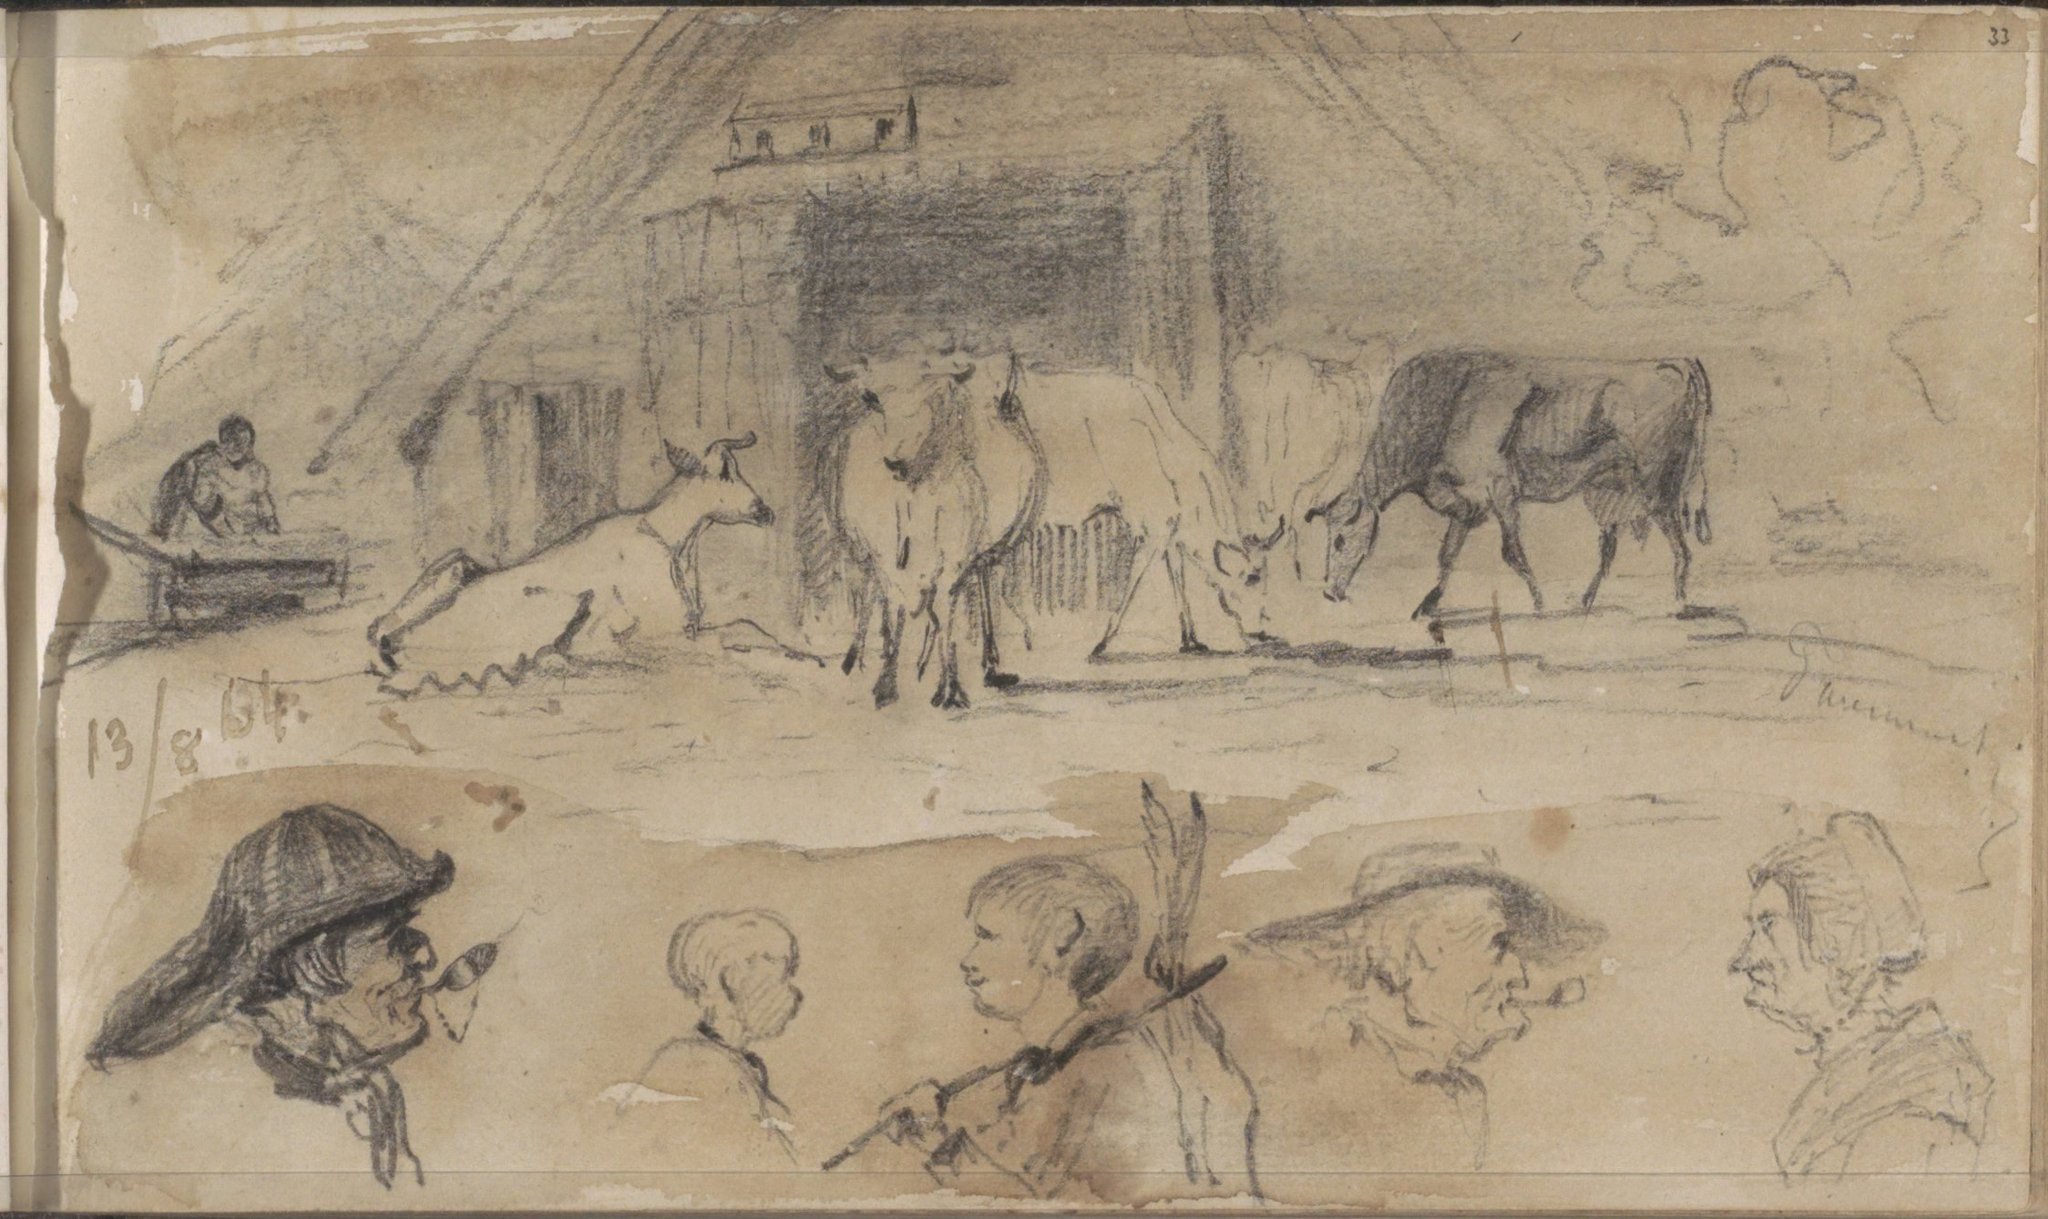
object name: sketchbook leaf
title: Koeien voor een schuur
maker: johannes tavenraat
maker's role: draughtsman, painter, print maker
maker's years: 1809-1881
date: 1808-1864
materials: ink, paper, pencil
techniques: brush, pen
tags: barn, head (human), cow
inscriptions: date: ‘13/8 64’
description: Tevens koppen van mannen, een jongen en een vrouw. Blad 33 recto uit een schetsboek met 98 bladen.